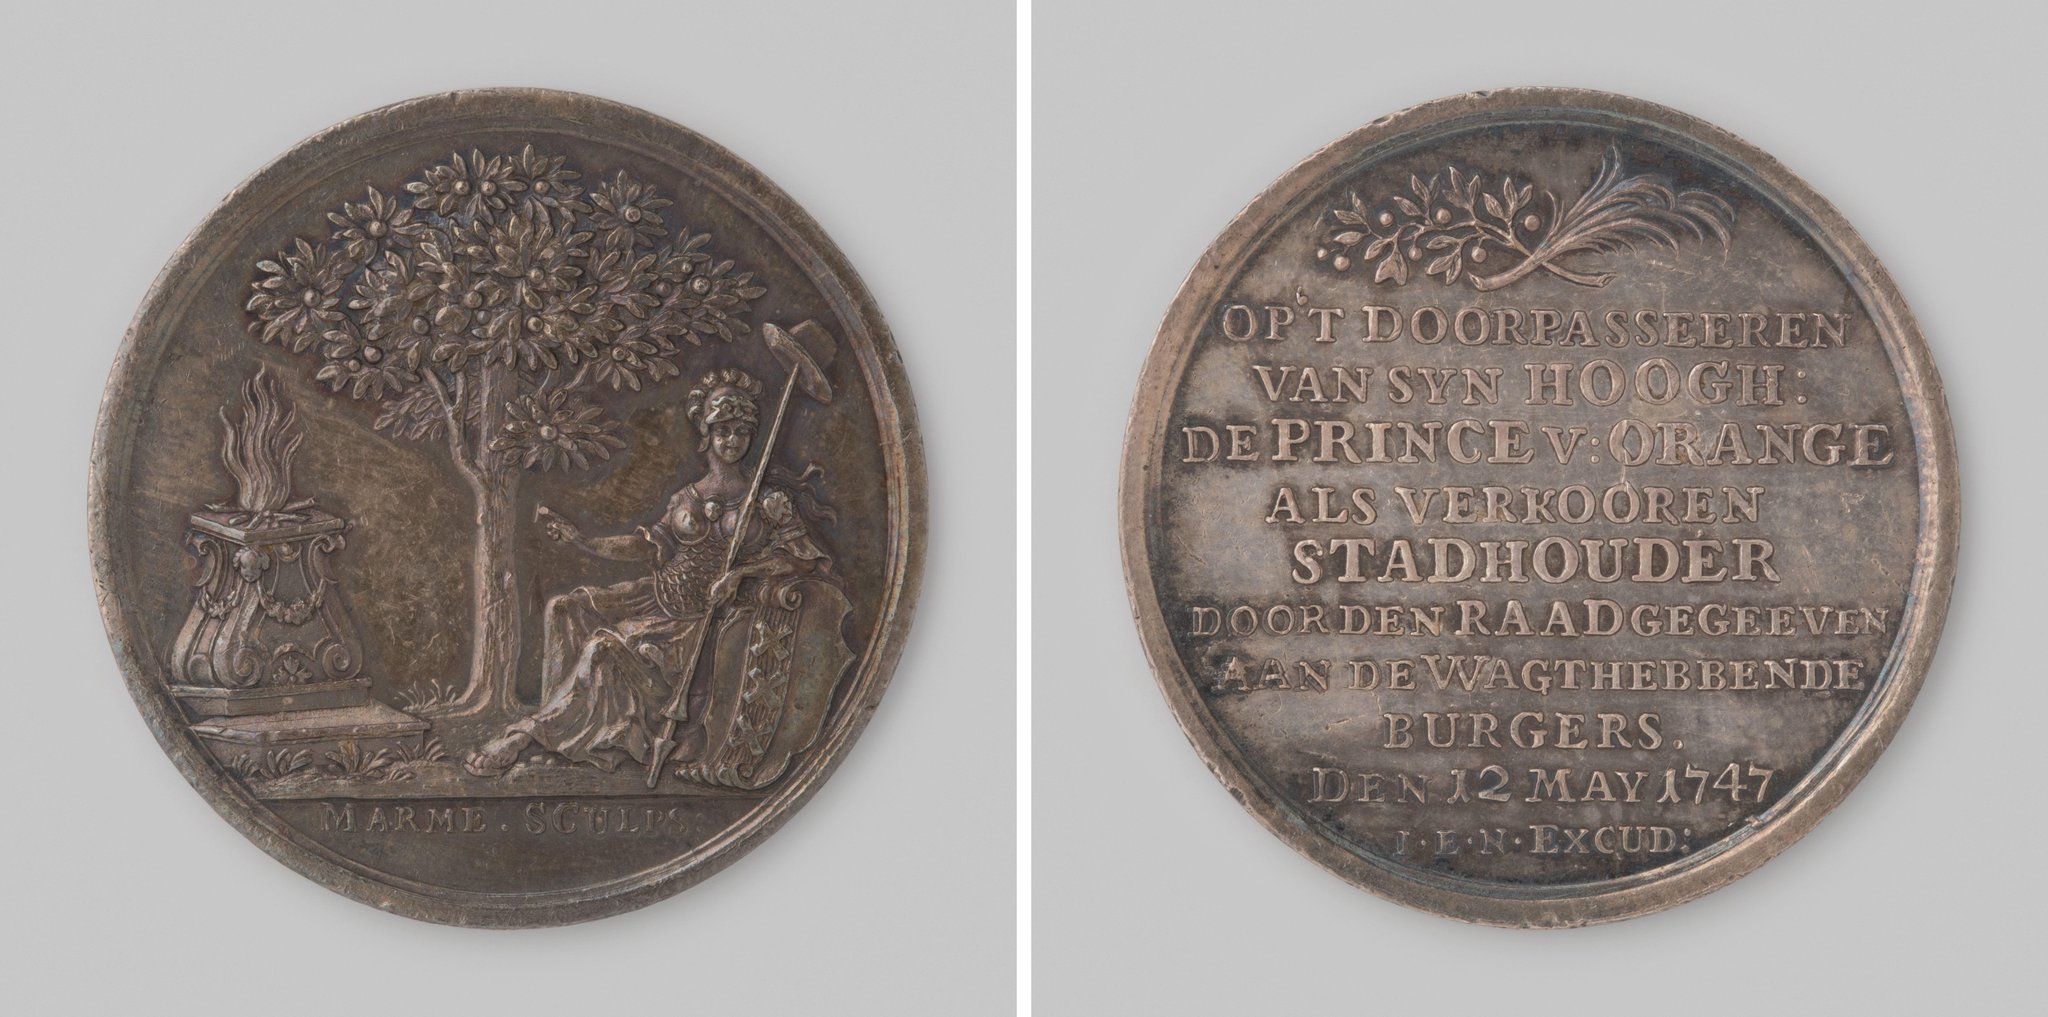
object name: history medal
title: Beloningspenning voor de burgerwacht bij het bezoek van Willem IV aan Amsterdam 1747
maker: johann conrad marmé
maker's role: die cutter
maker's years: 1710-1772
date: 1747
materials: silver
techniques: striking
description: Zilveren penning, op de voorzijde Amsterdam als Minerva tronend naast een oranjeboom en een brandend altaar, met afsnedetekst, op de keerzijde tien regels tekst onder gekruiste lauwer- en palmtakken.